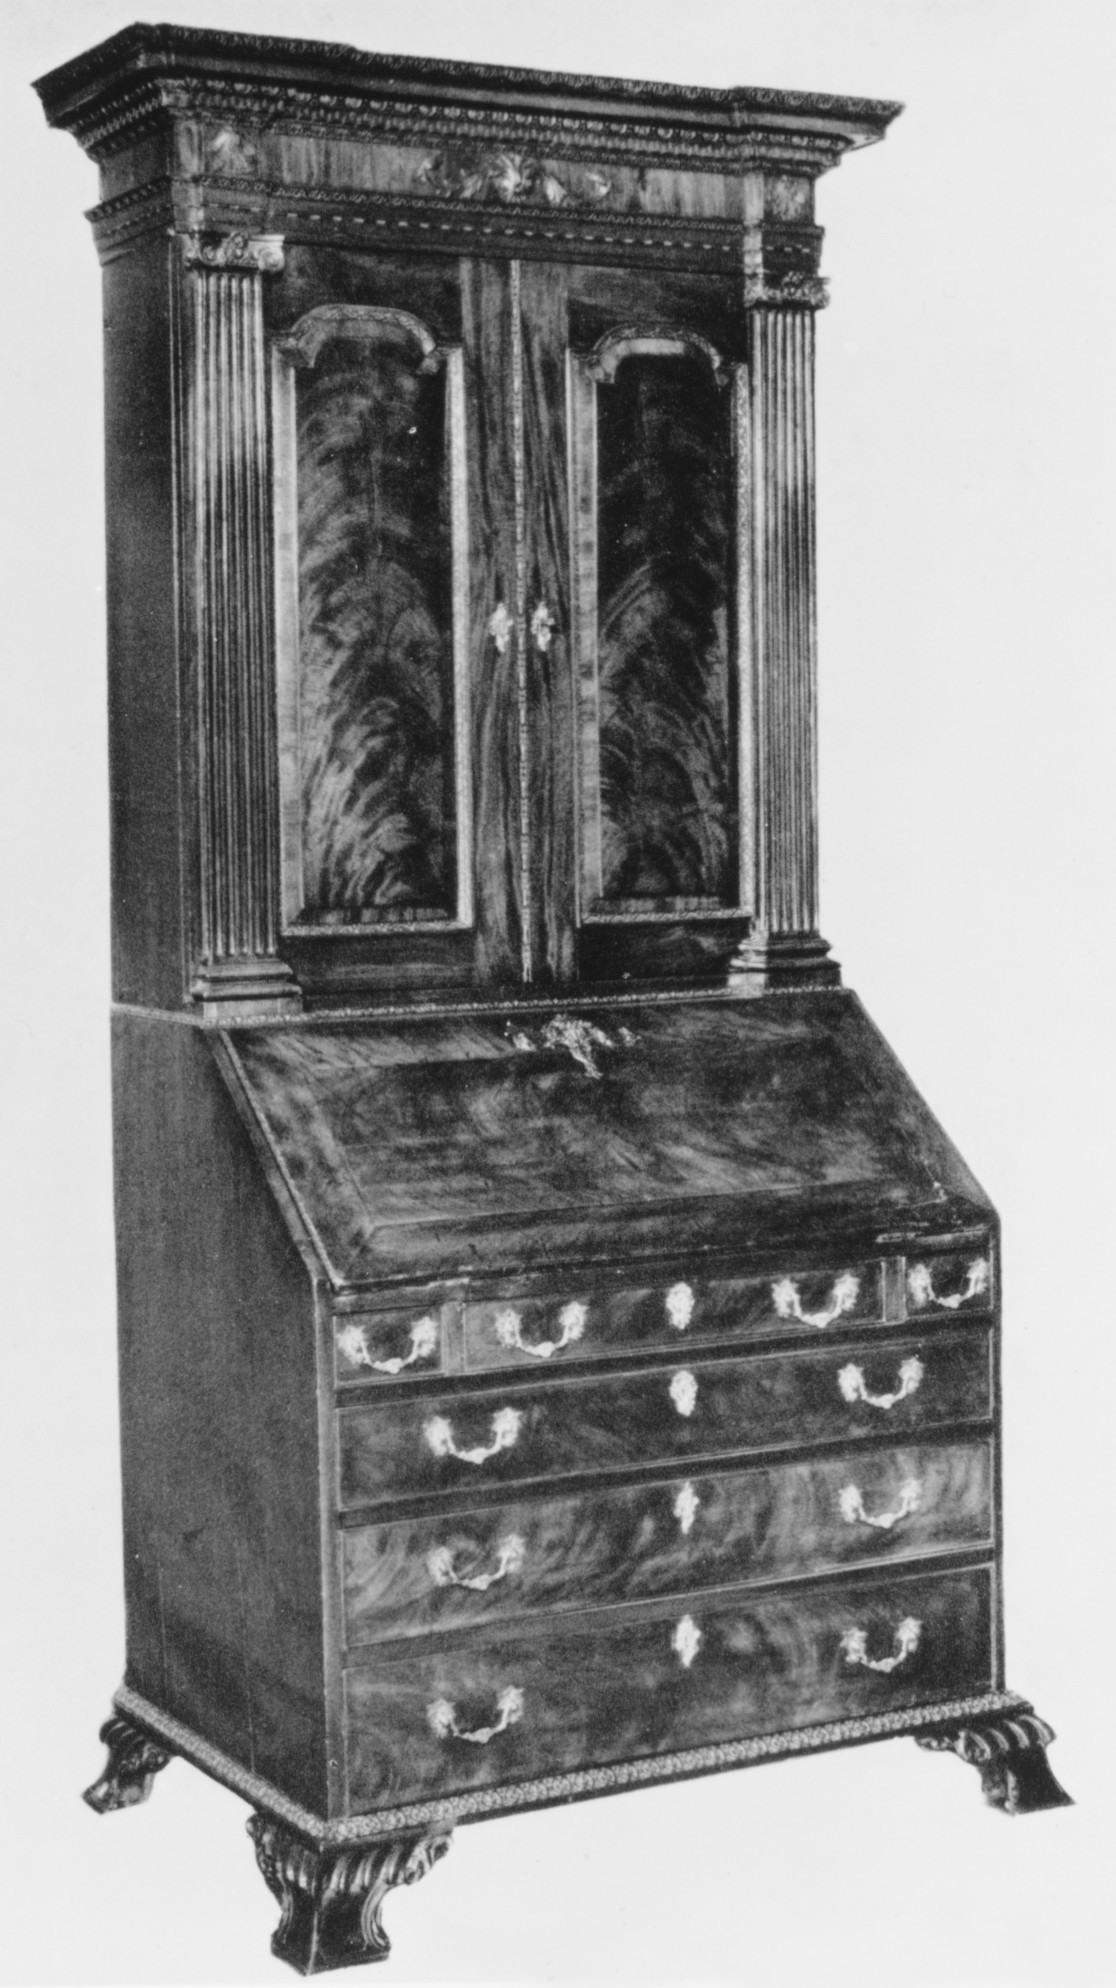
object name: bureau bookcase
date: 1755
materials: wood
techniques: carving, veneering